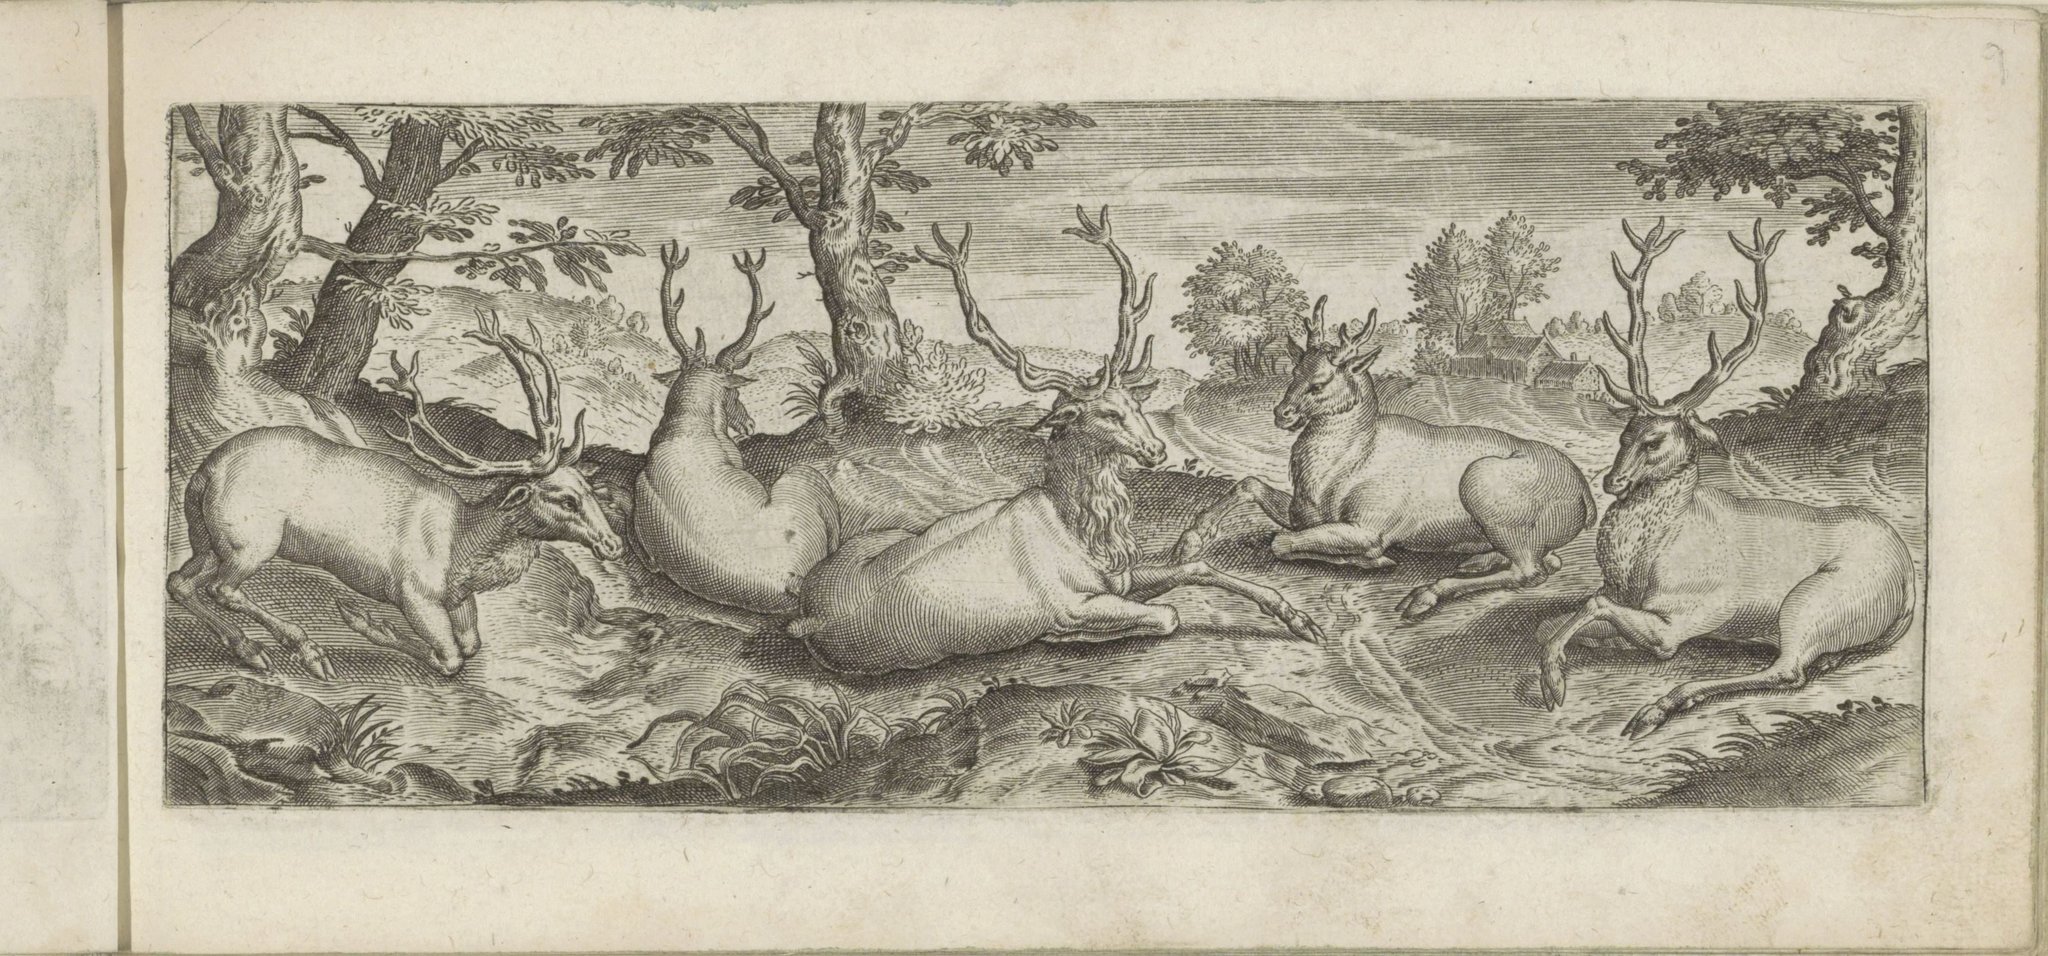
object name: print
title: Animalium Quadrupedum Omnis Generis Verae et Artificiosissimae Delineationes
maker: eduwart van hoeswinckel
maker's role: publisher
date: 1583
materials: paper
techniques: engraving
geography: antwerp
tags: hoofed animals: deer, landscapes in the temperate zone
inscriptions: collector's mark: Lugt 2228, collector's mark: Lugt 2760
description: Vijf liggende herten in een landschap. Deze prent maakt deel uit van een album.